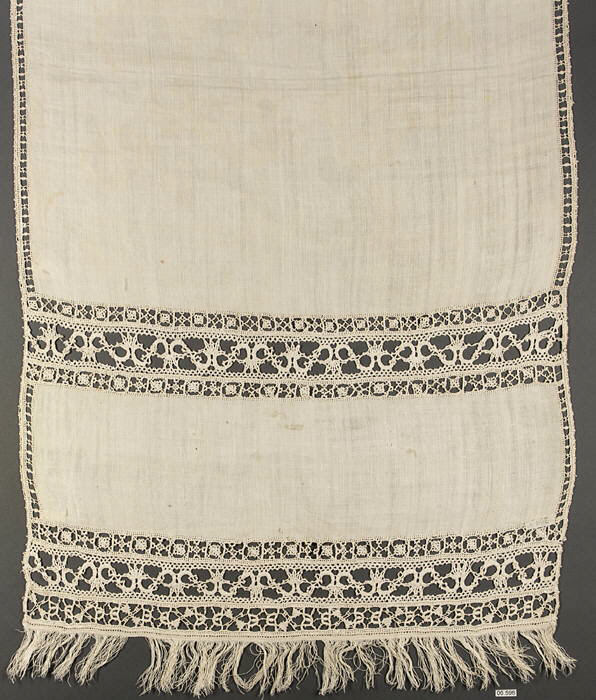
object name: towel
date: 1567-1600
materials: linen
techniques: lace